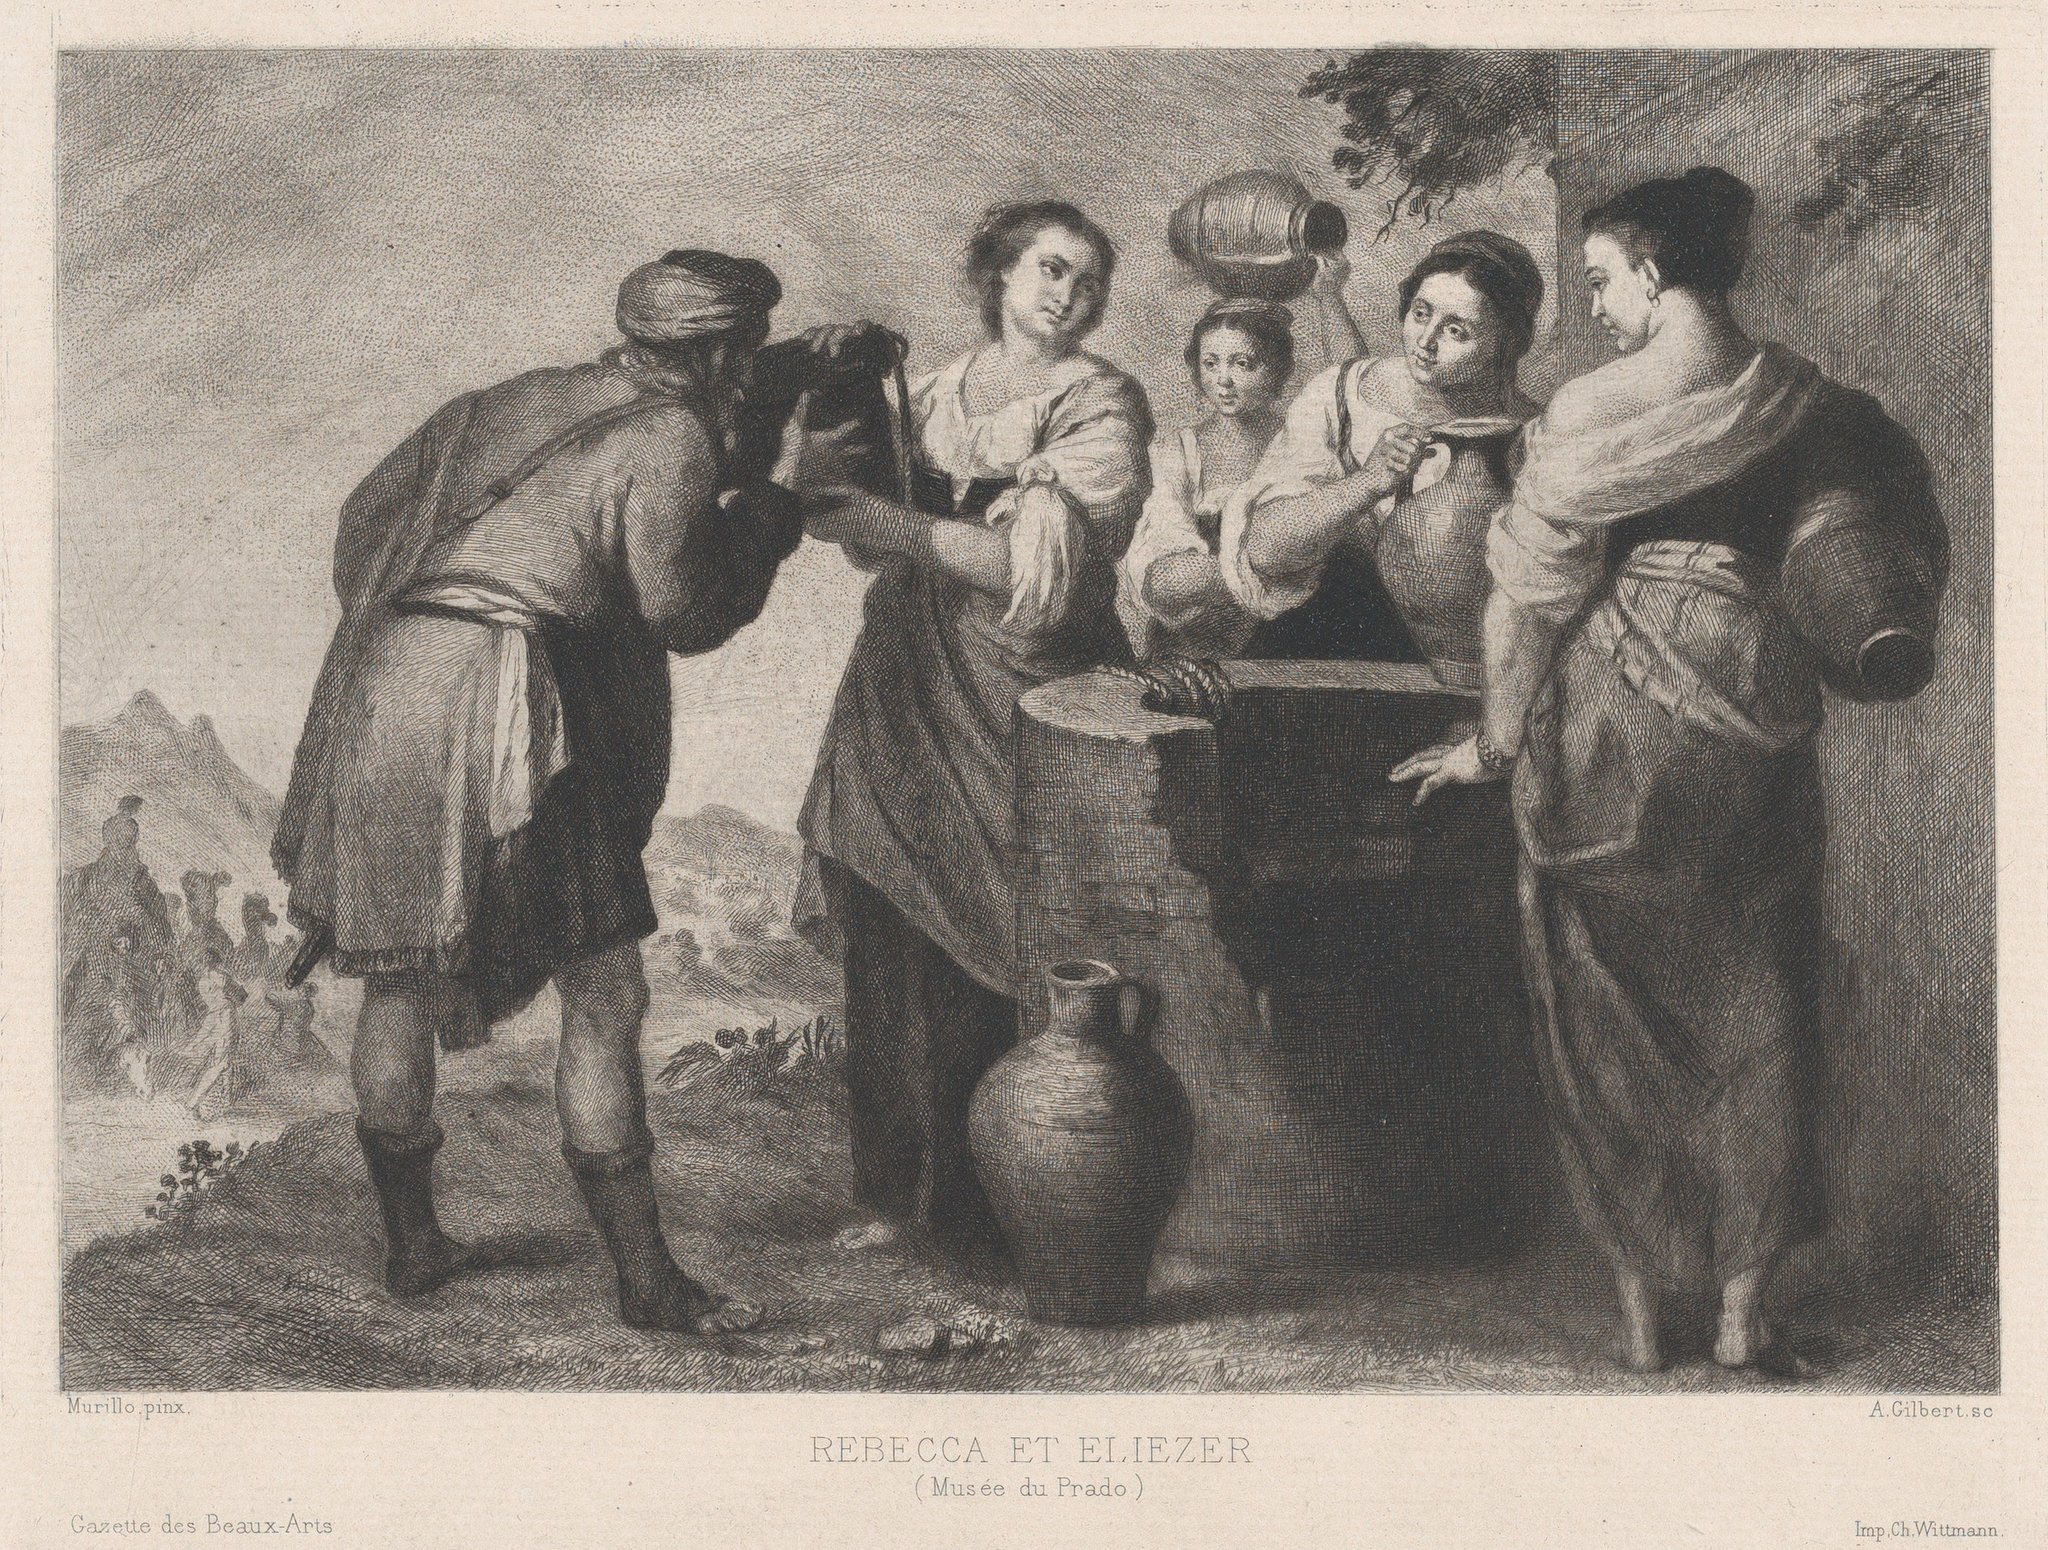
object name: print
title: Rebecca and Eliezer, from "Gazette des Beaux-Arts"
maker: achille-isidore gilbert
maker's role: artist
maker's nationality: french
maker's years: 1828-1899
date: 1880-1899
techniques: etching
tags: wells,men,women,drinking